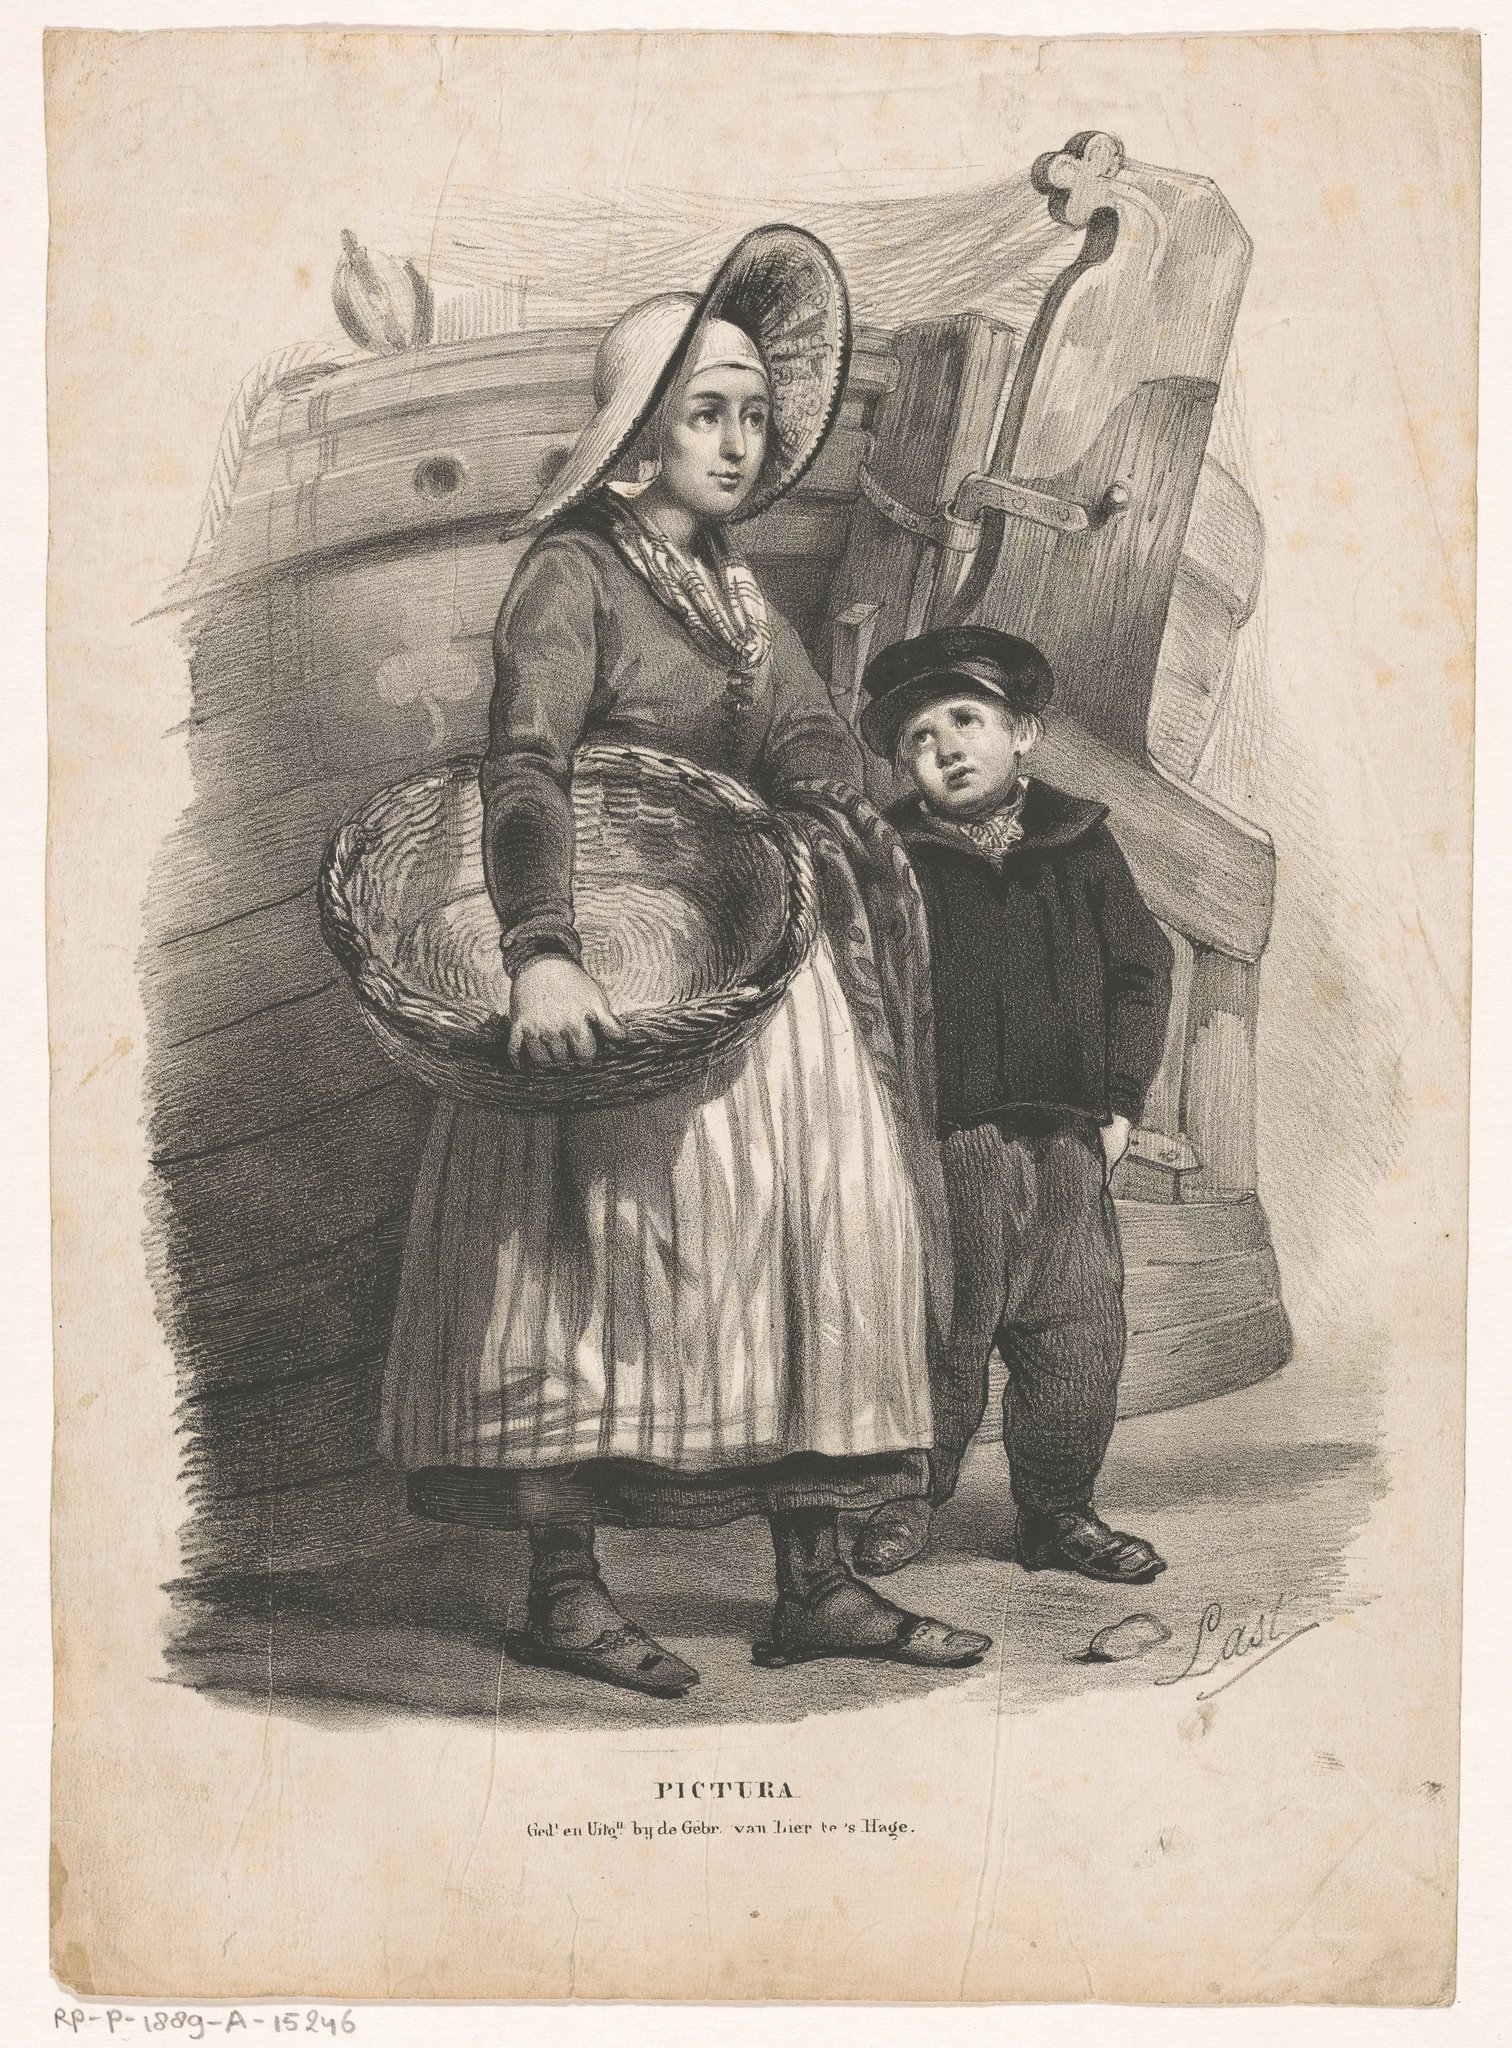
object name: print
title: Pictura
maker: carel christiaan antony last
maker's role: print maker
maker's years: 1808-1876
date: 1834-1850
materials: paper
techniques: lithograph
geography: the hague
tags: adult woman, sailing-ship, sailing-boat, fisherman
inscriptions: collector's mark: Lugt 2228